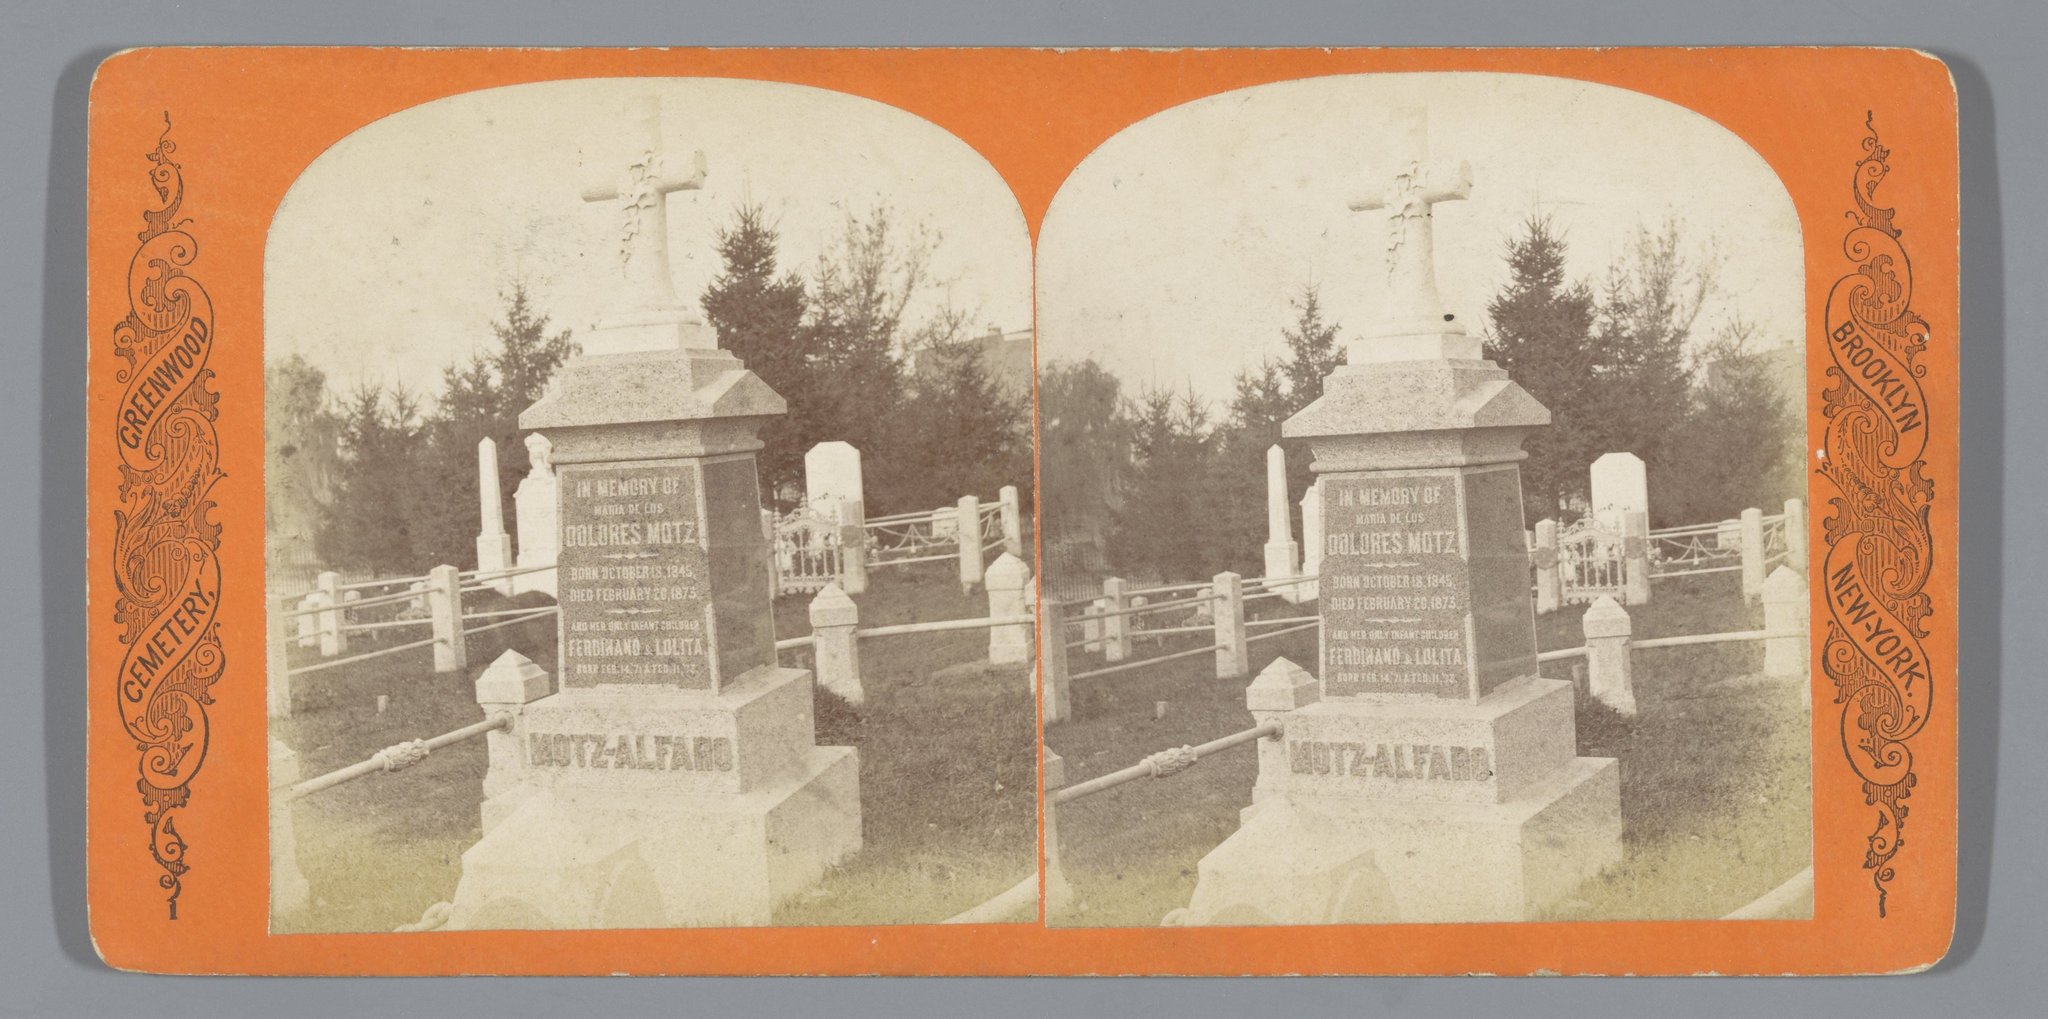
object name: stereograph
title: Greenwood Cemetery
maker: Anonymous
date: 1868-1890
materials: cardboard, paper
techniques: albumen print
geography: new york city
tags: urn, new york (city)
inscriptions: retailer's mark: ‘FROM/ B. and B. BAZAR./ 677 & 679 Fulton St./ BROOKLYN.’, inscription: ‘The Main Entrance (Five Views)/ Franklin Ave. Entrance/ (...)’